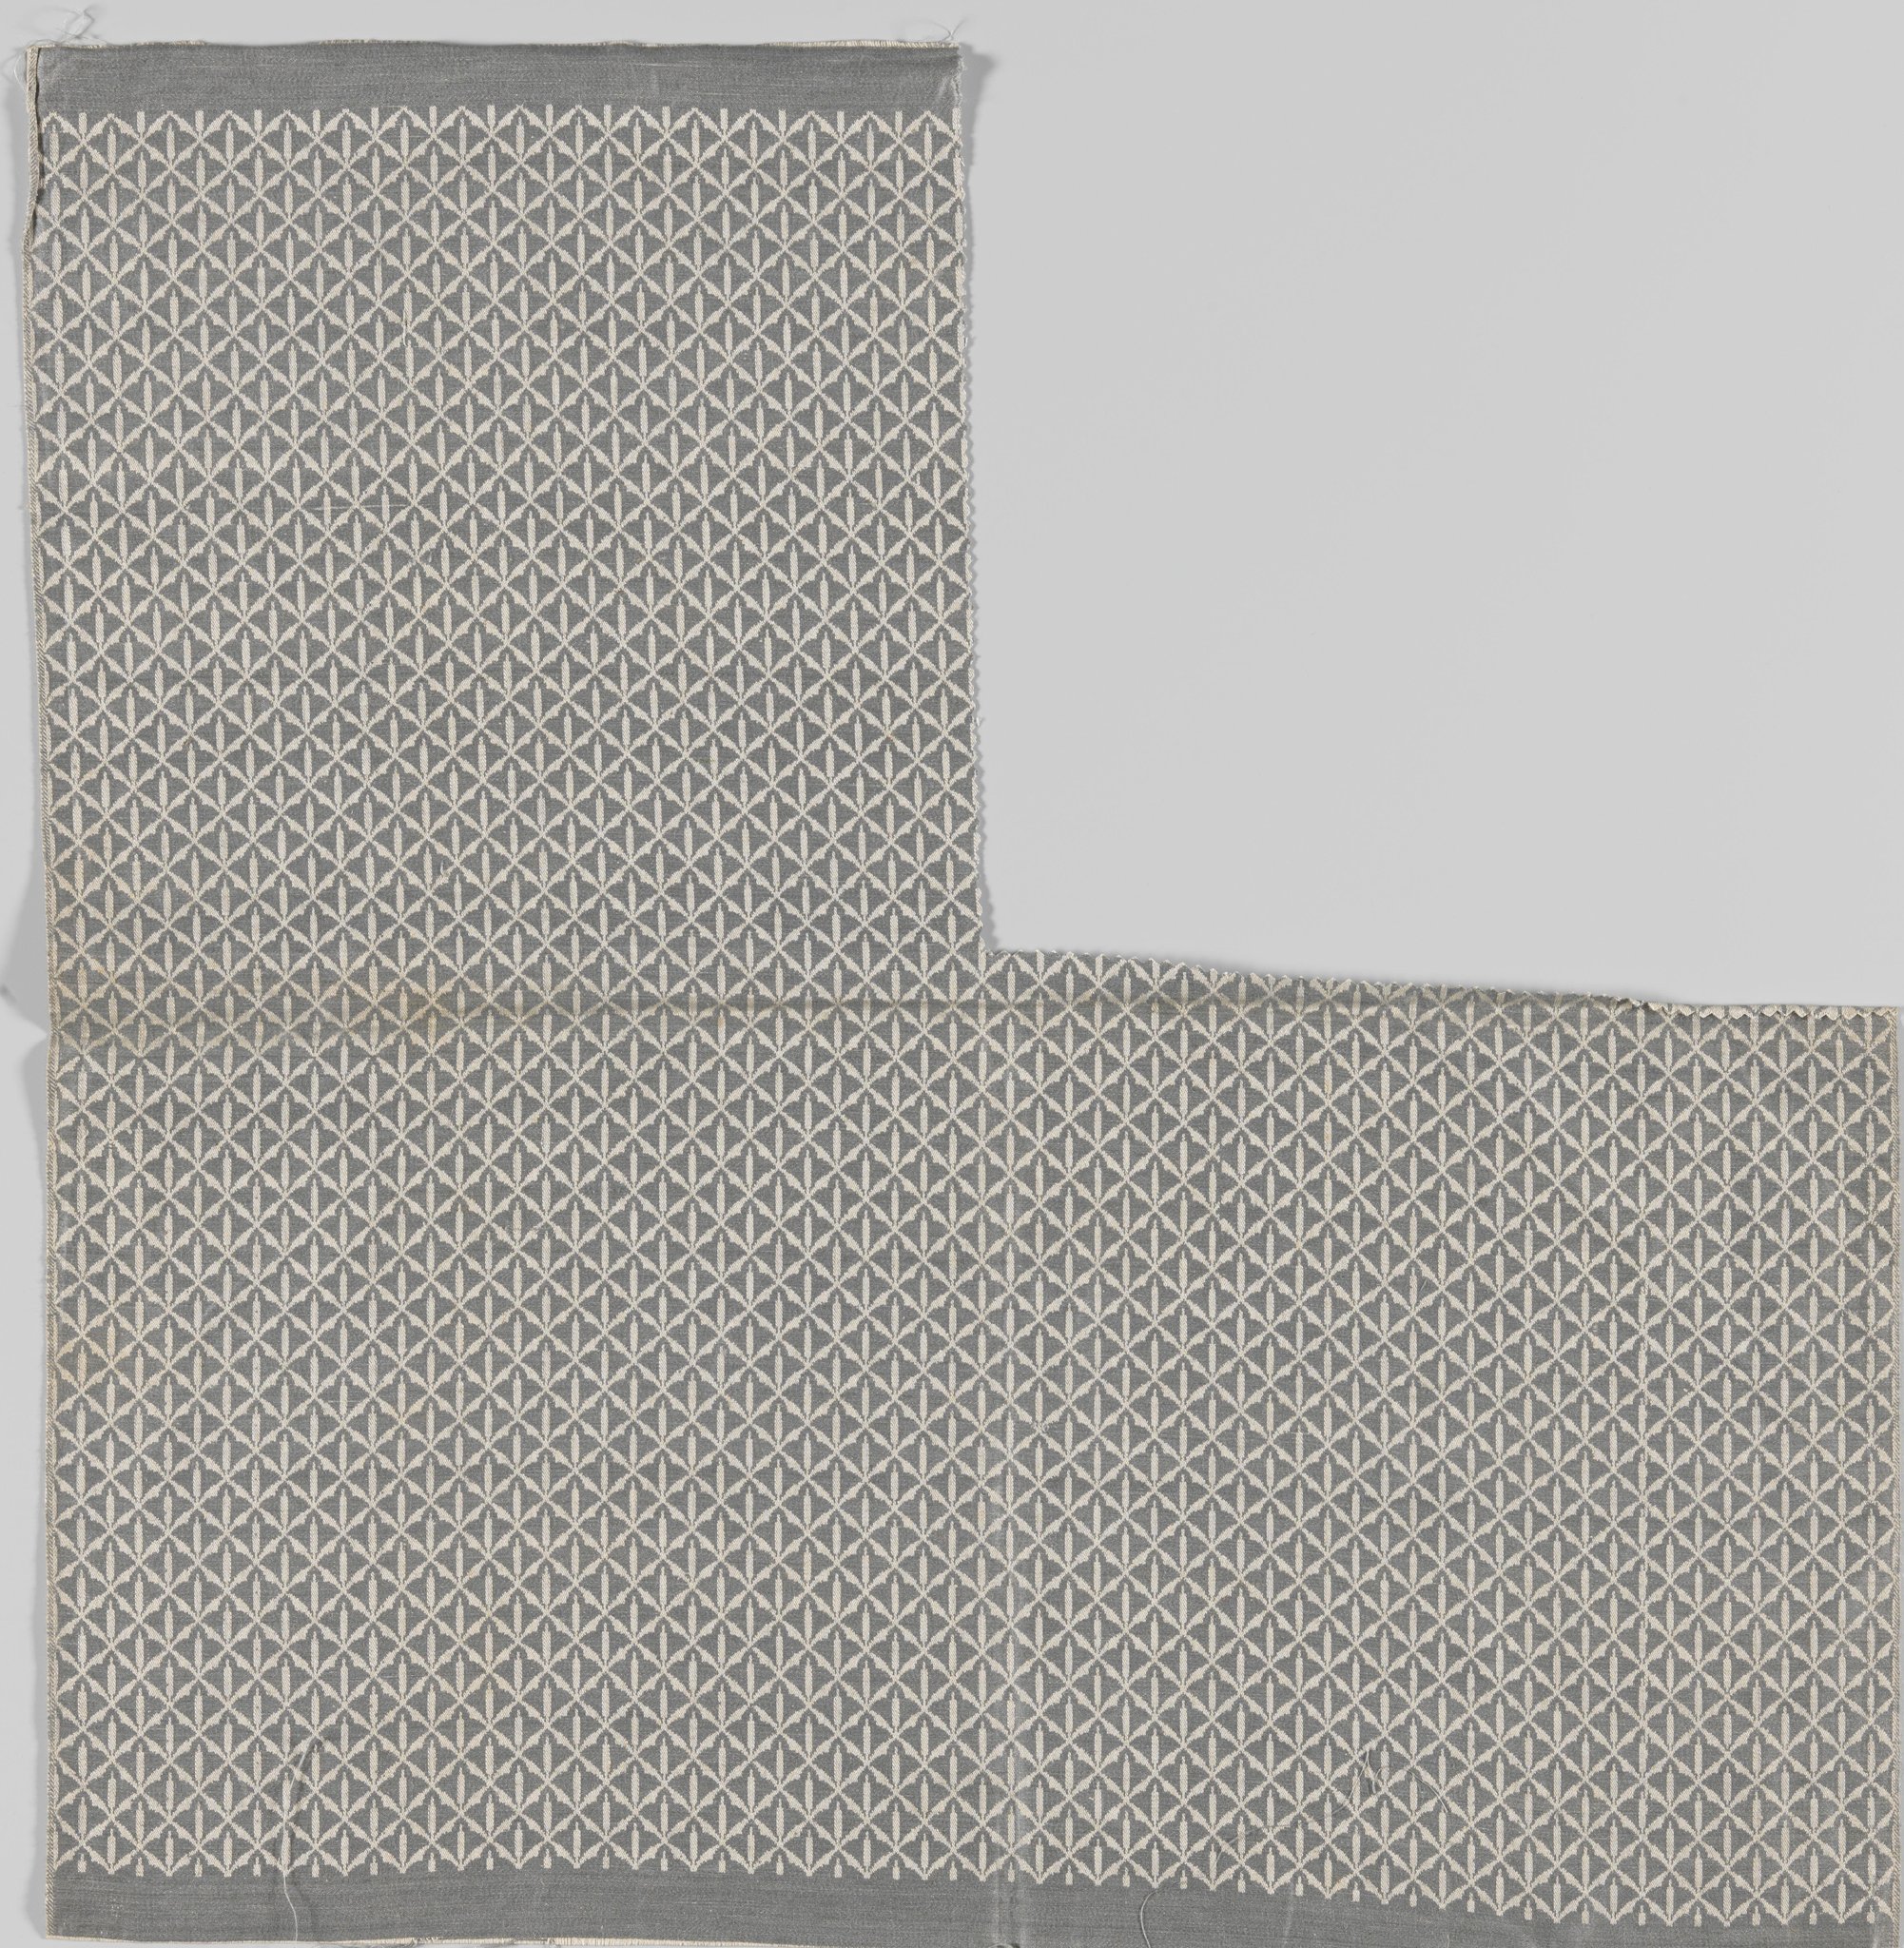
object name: upholstery fabric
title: Staal bespanningsstof van linnendamast met ruitmotief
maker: chris lebeau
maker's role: draughtsman, print maker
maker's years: 1878-1945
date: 1911-1915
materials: linen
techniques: damask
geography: eindhoven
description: Staal bespanningsstof van linnendamast met ruitmotief in naturel op een lichtblauwe grond.